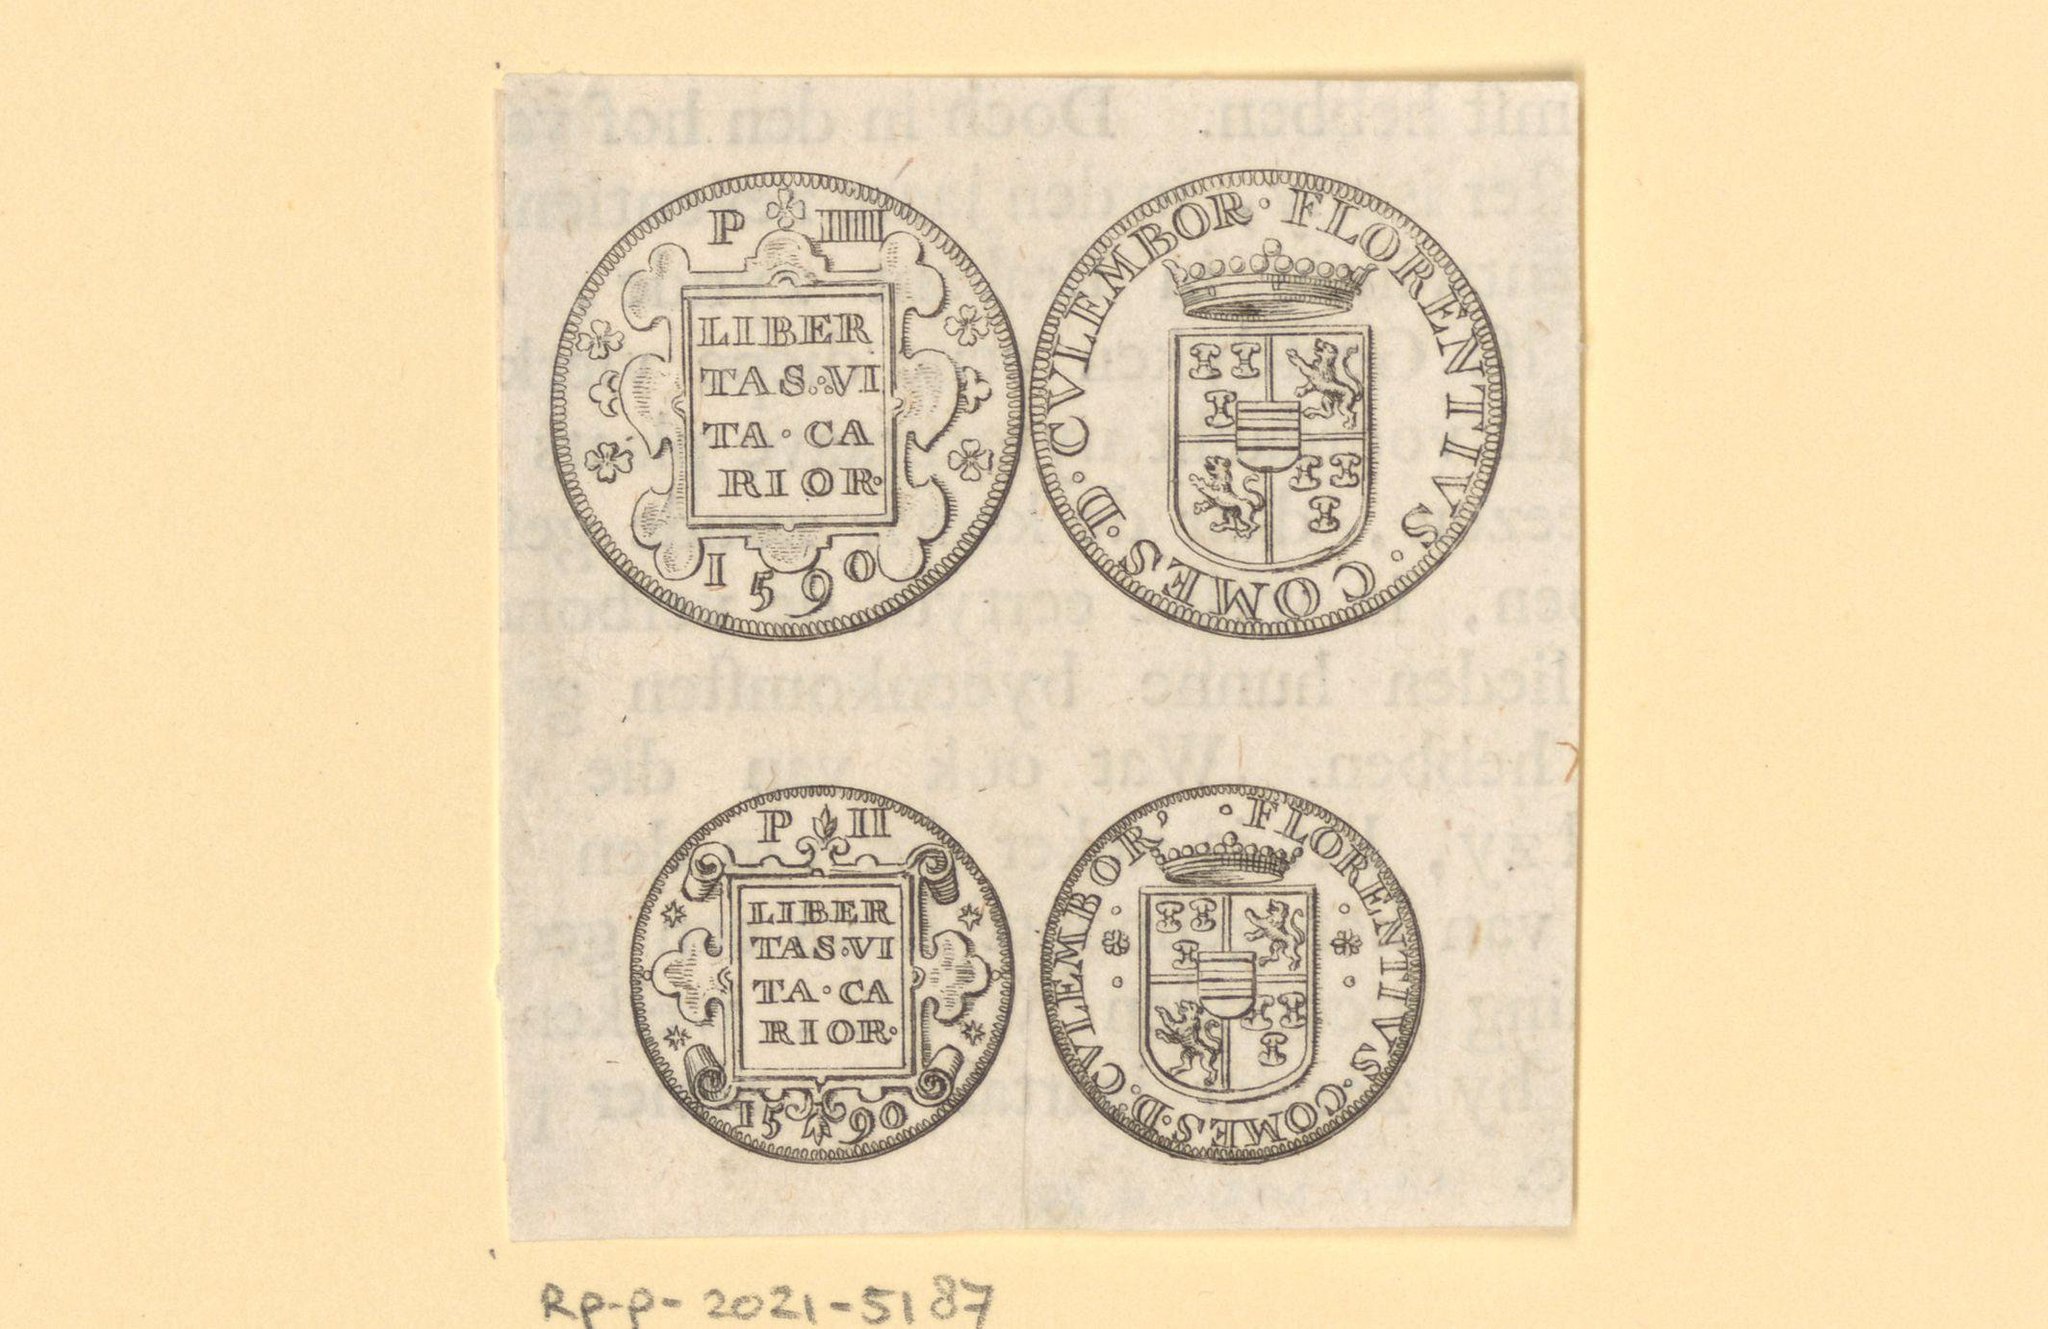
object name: print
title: Penningen met tekst en wapenschild van Floris van Pallandt, graaf van Kuylenburg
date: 1723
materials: paper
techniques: engraving, etching, letterpress printing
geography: the hague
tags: trade token, private coin, armorial bearing, heraldry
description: Prent uit: Loon, Gerard van. Beschrijving der Nederlandsche historiepenningen of beknopt verhaal van 't gene sedert de overdracht der heerschappye van keyzer Karel den Vyfden op koning Philips zynen zoon, tot het sluyten van den Uytrechtschen vreede, in de zeventien Nederlandsche gewesten is voorgevallen. Den Haag: Christiaan van Lom, Pierre Gosse, Rutgert Alberts en Pieter de Hondt, 1723, dl. 1.